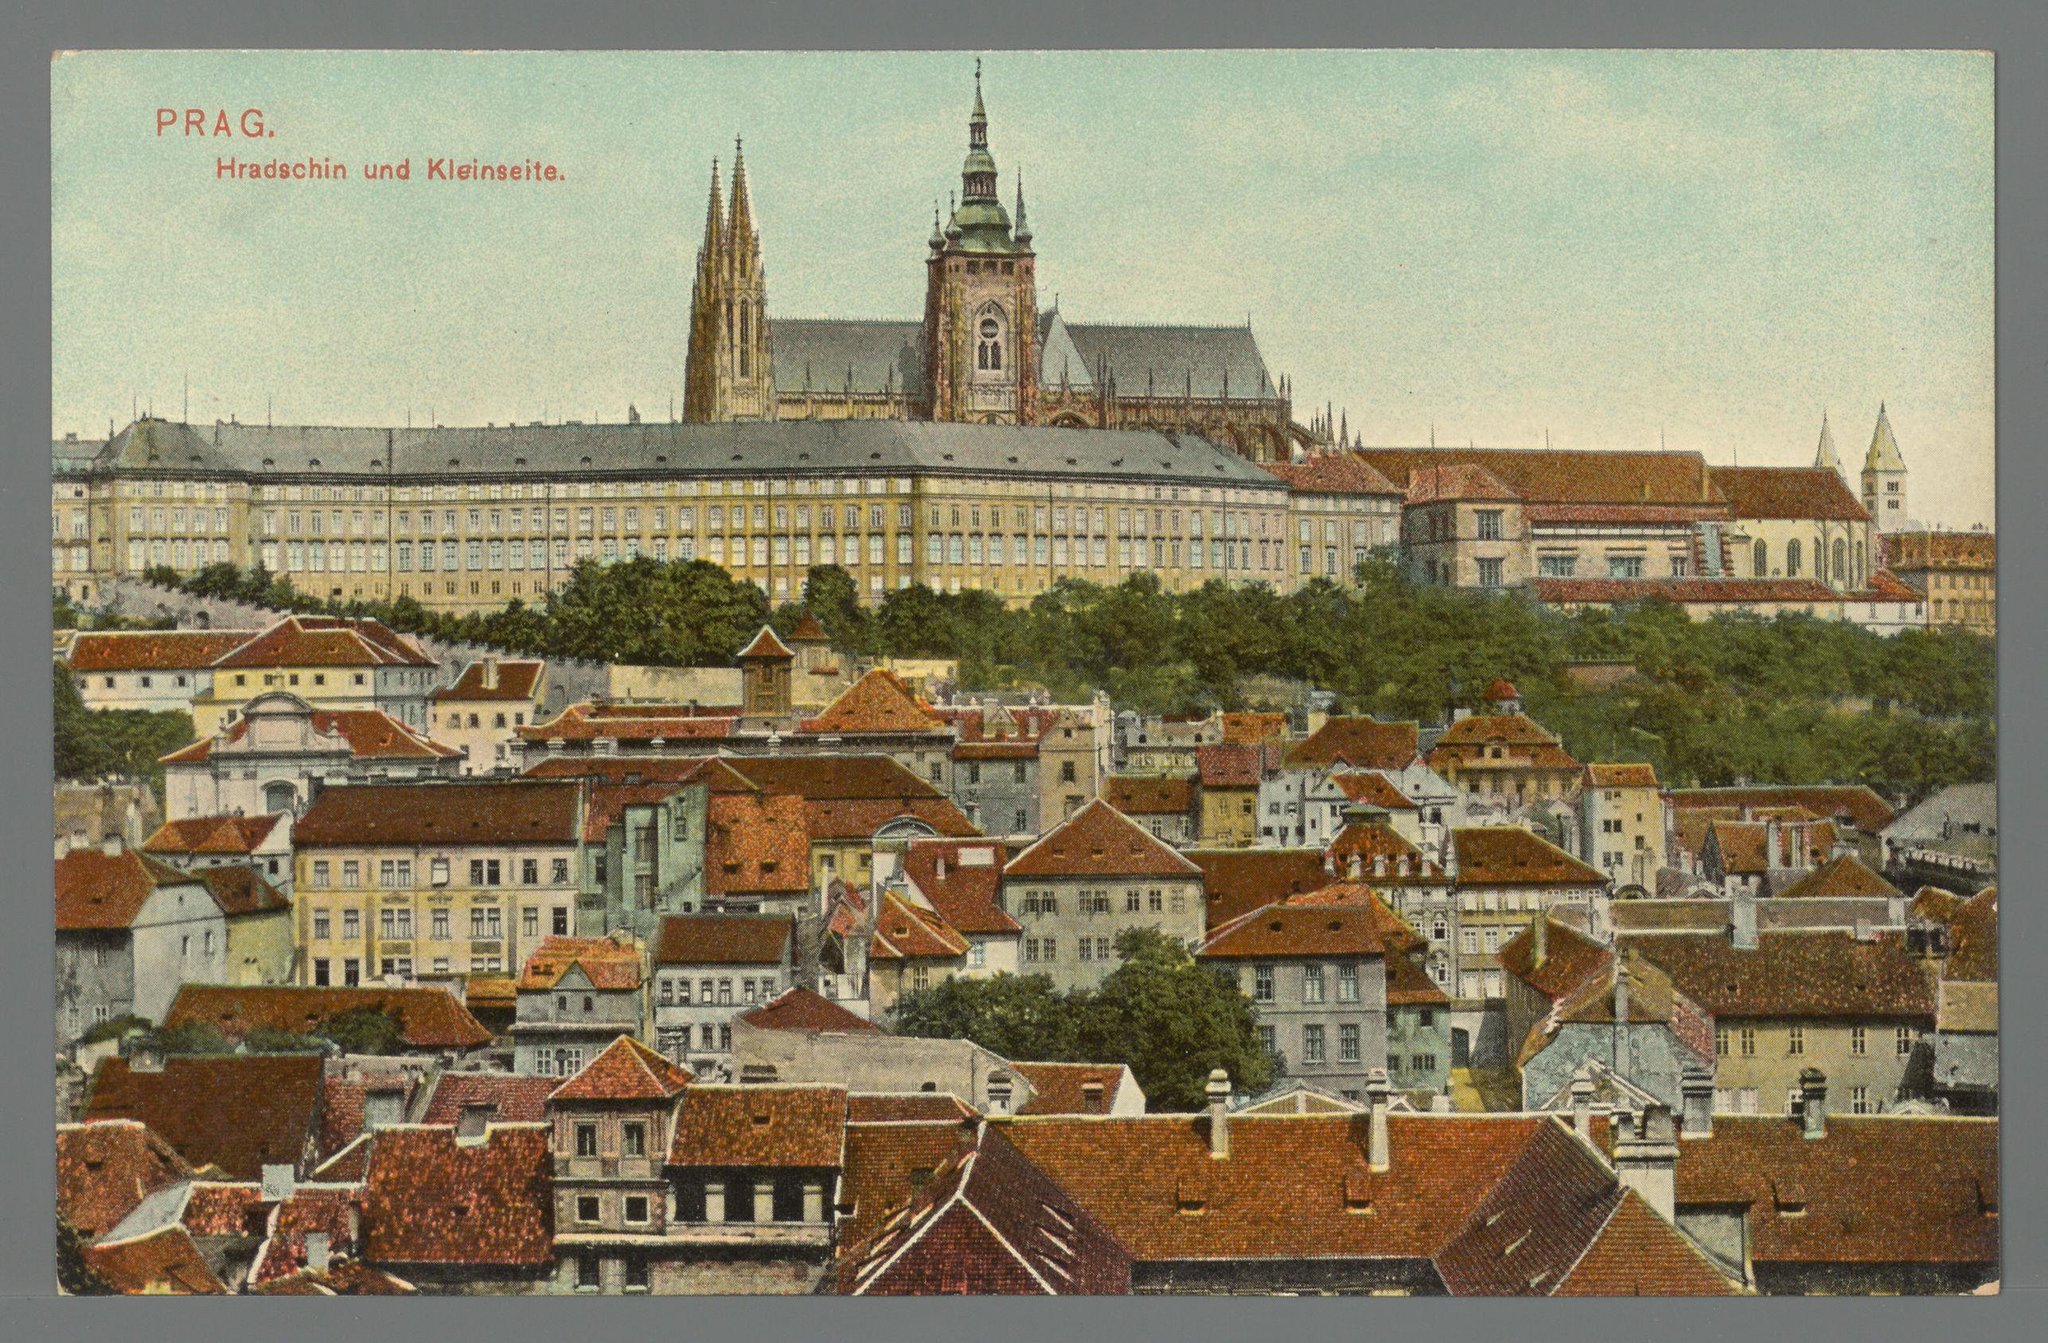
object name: photomechanical print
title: Prag. Hradschin und Kleinseite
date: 1907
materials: cardboard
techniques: lithograph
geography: prague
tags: city-view, and landscape with man-made constructions, castle, church (exterior)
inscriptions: date